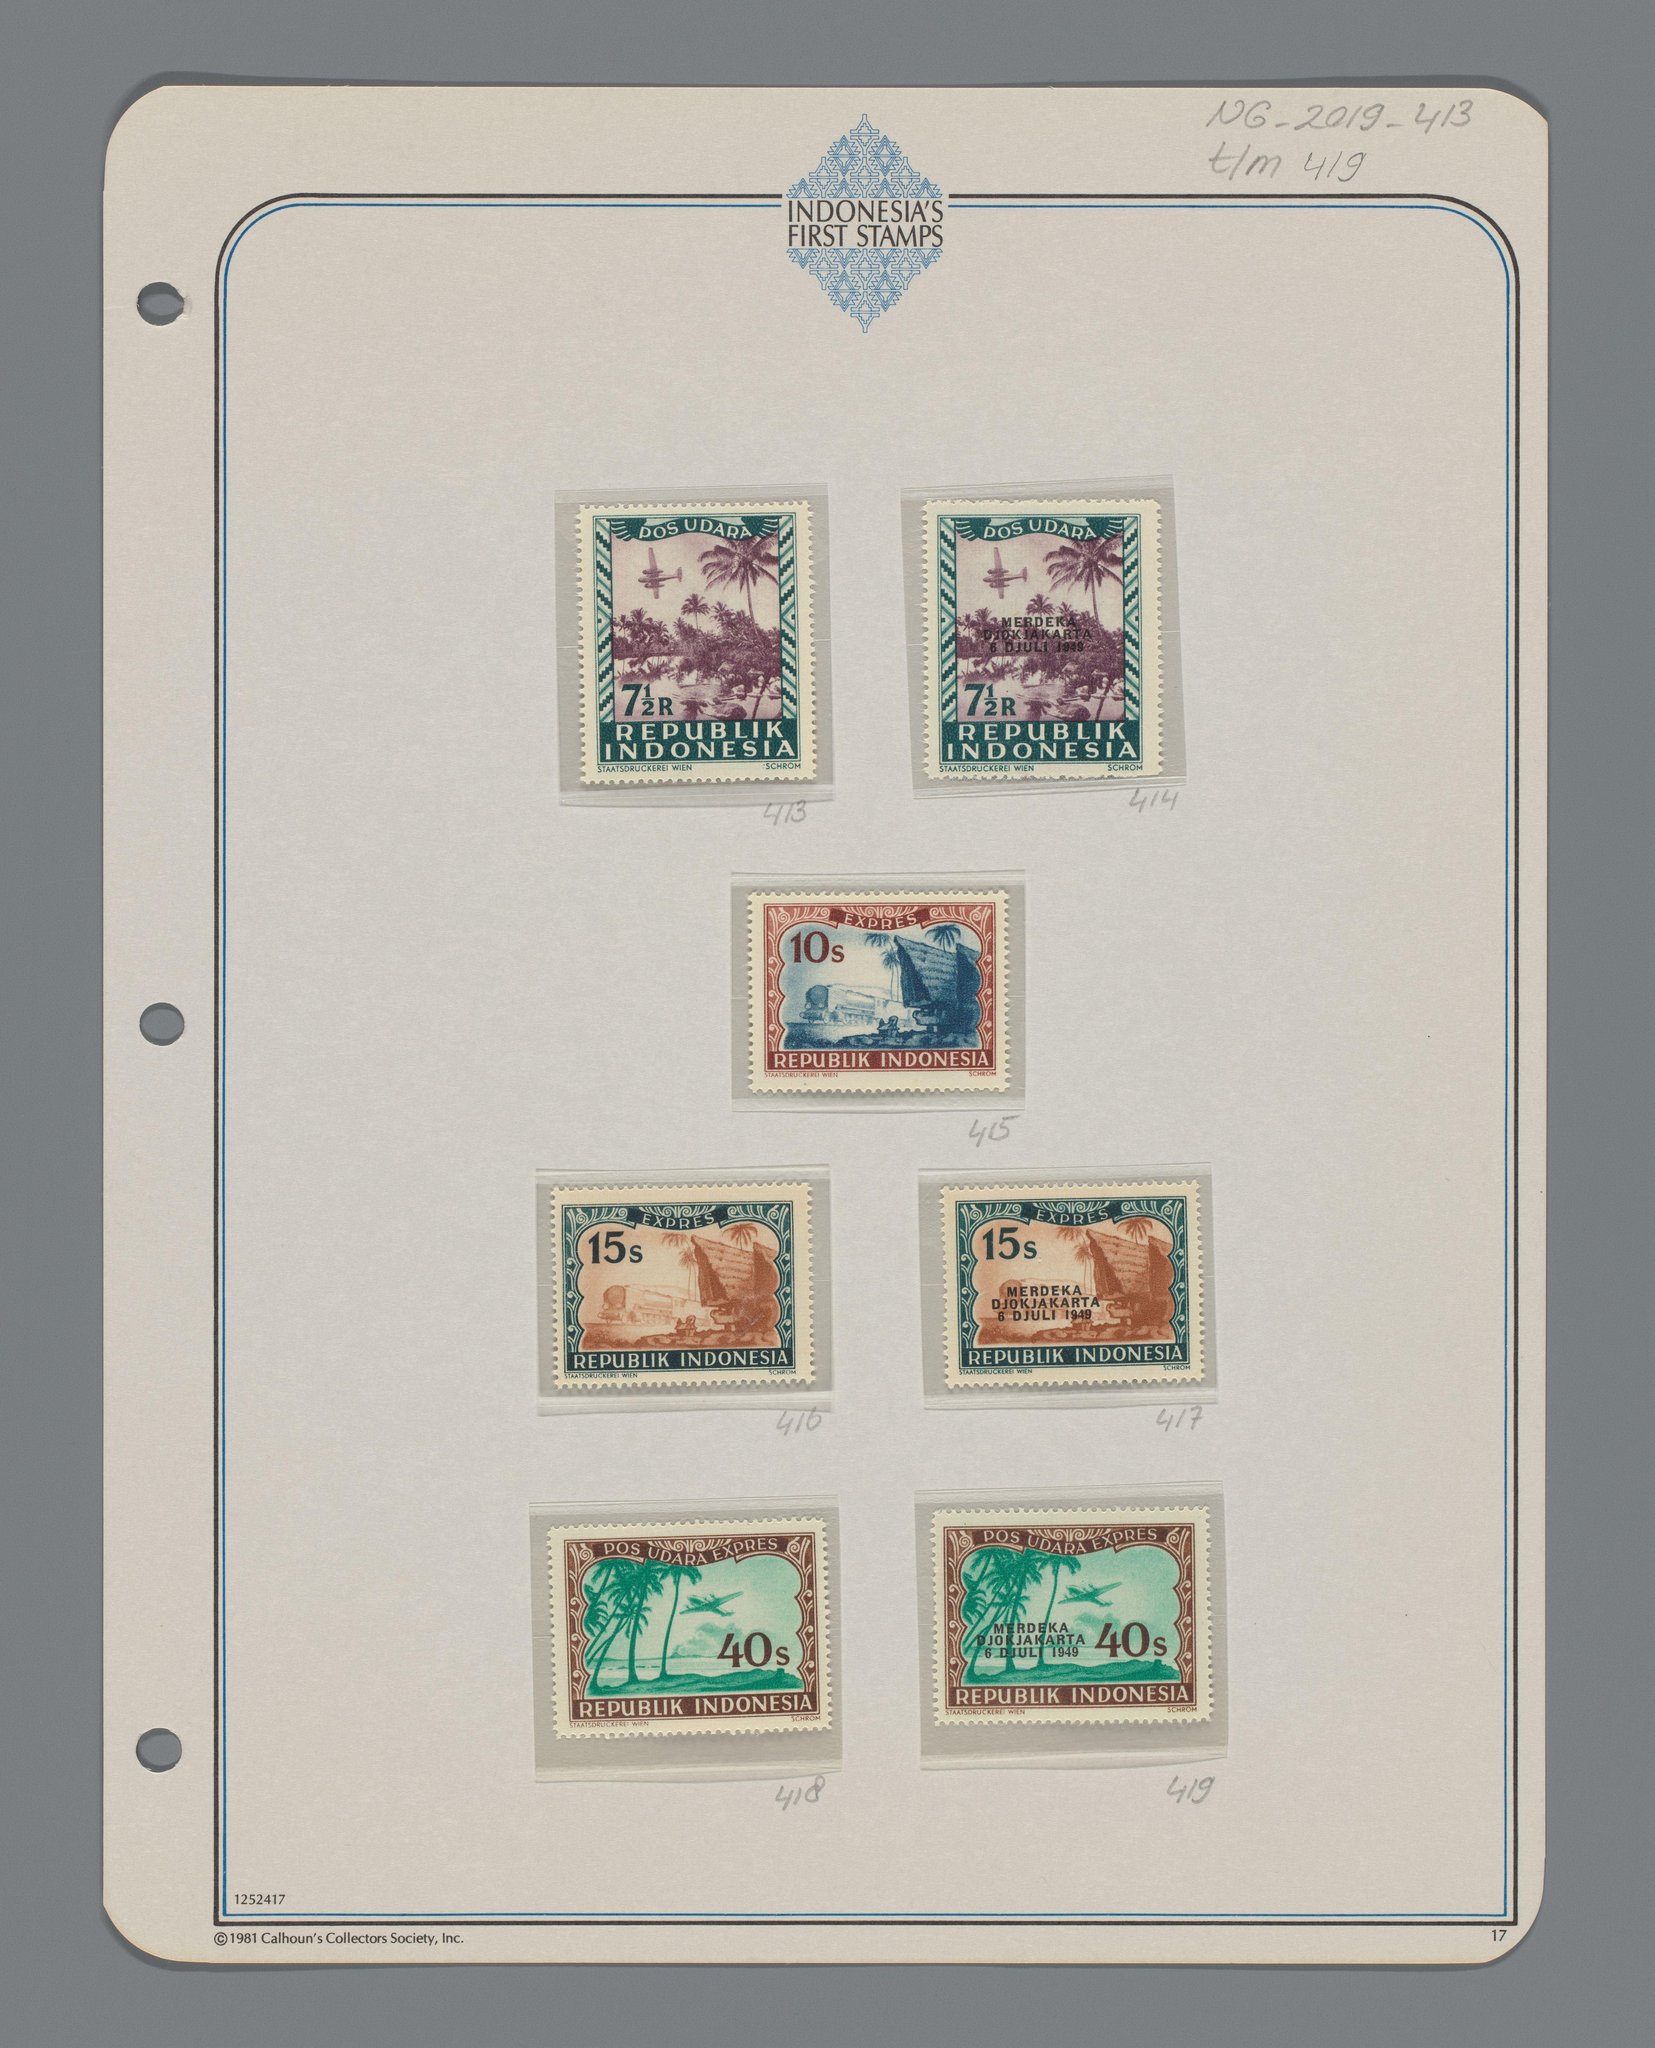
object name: postage stamp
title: Postzegel Republik Indonesia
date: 1949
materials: paper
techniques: photoaquatint, engraving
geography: vienna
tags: indonesia